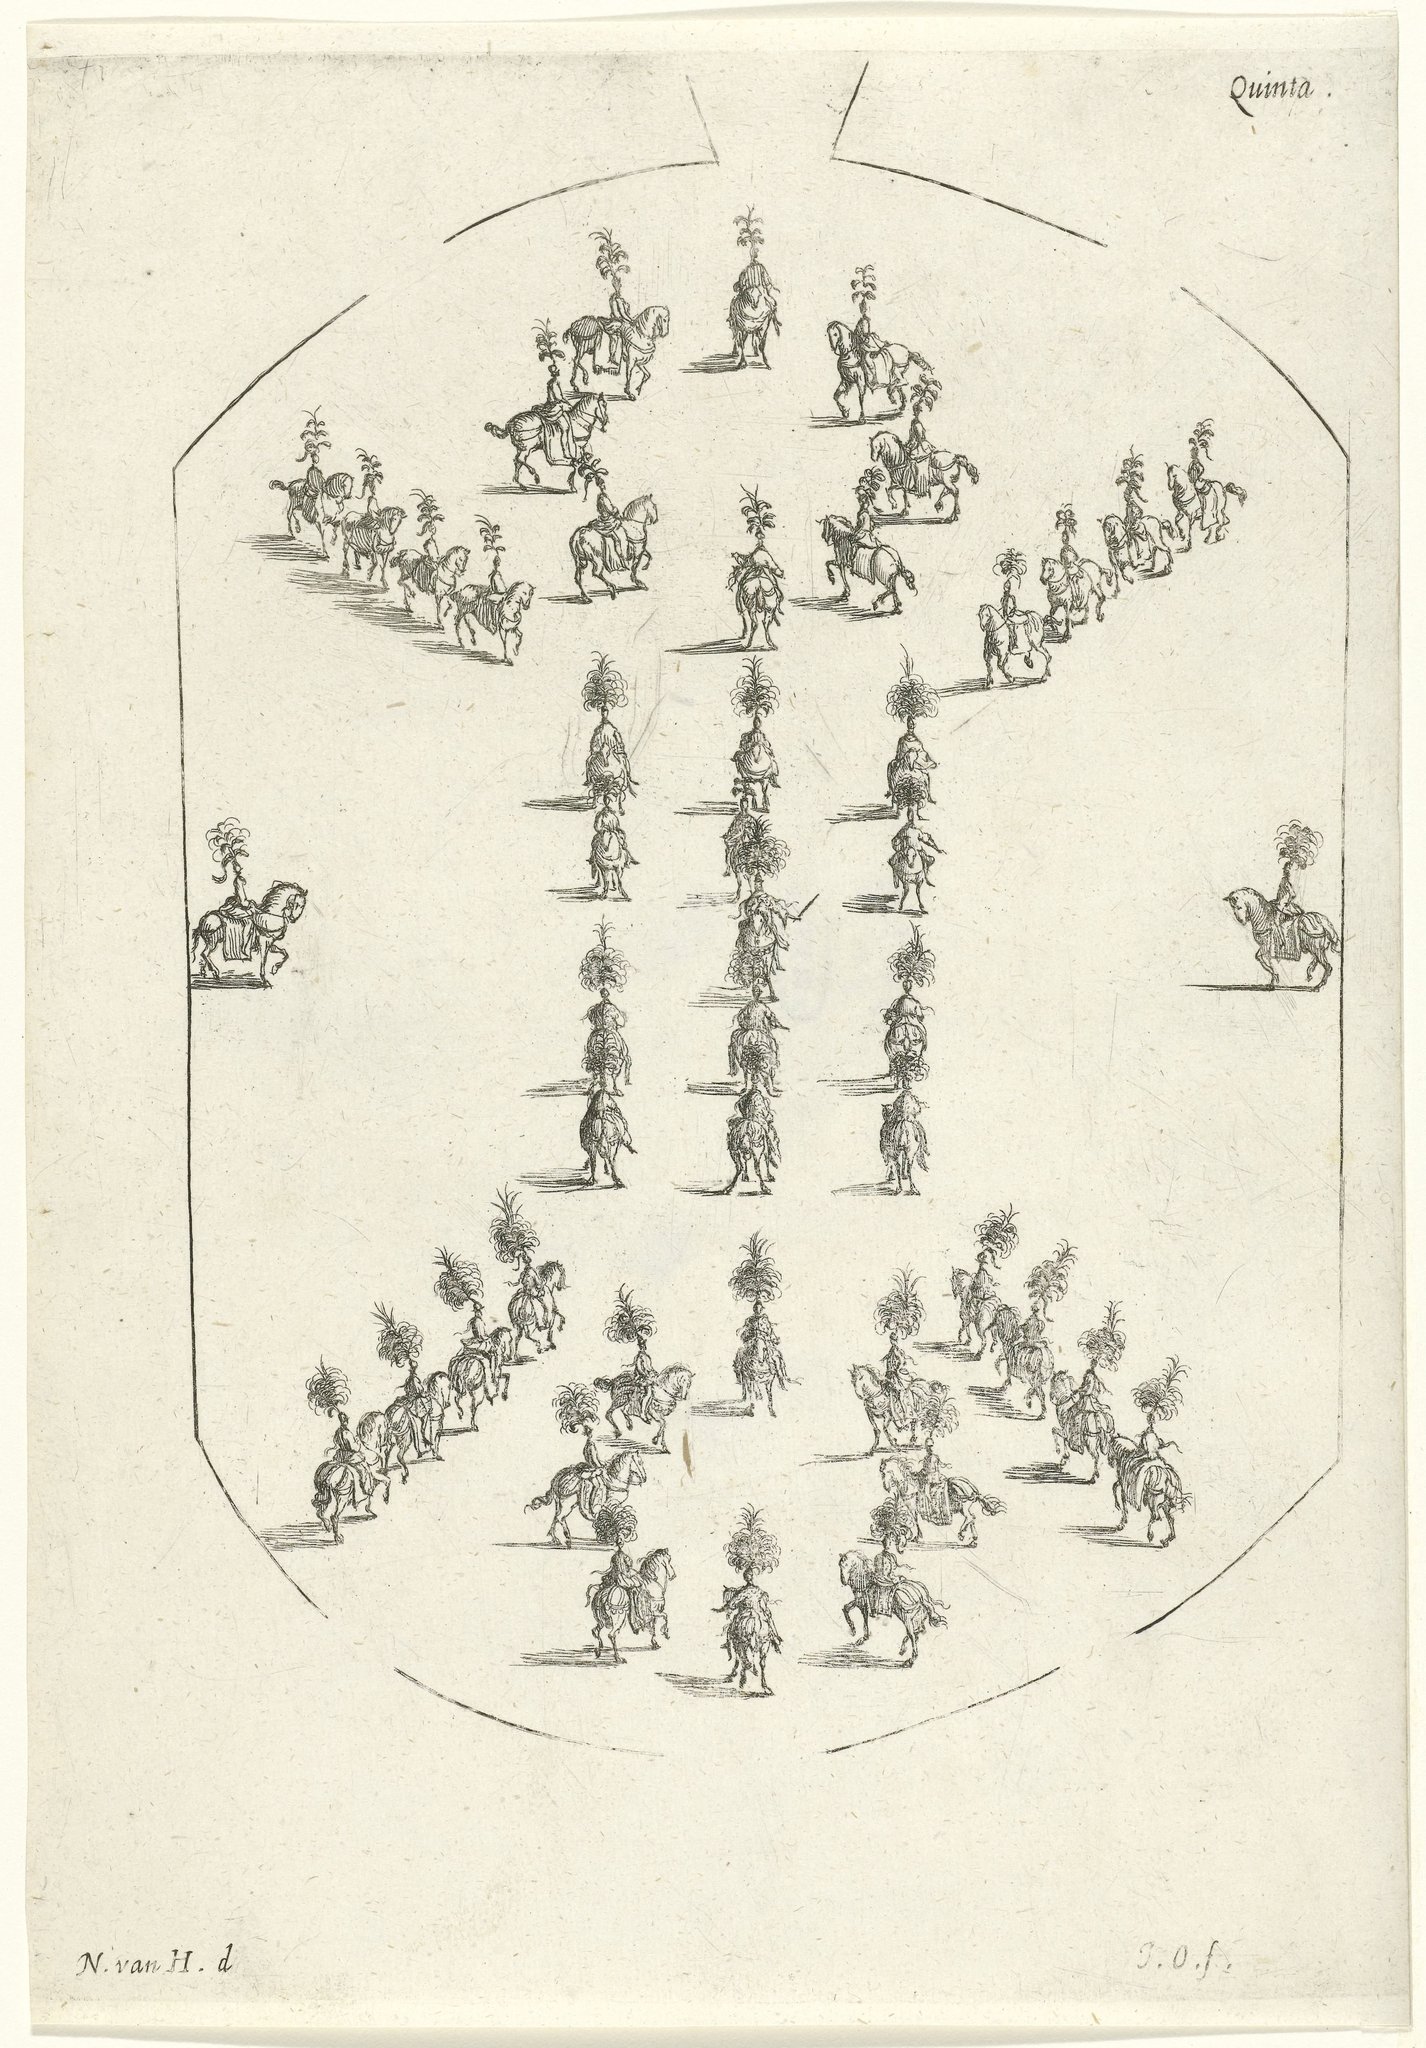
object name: print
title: Ruiterformaties (Quinta)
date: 1667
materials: paper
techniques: etching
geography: vienna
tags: high-school riding, military honours (+ cavalry, horsemen)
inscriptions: collector's mark: Lugt 2228